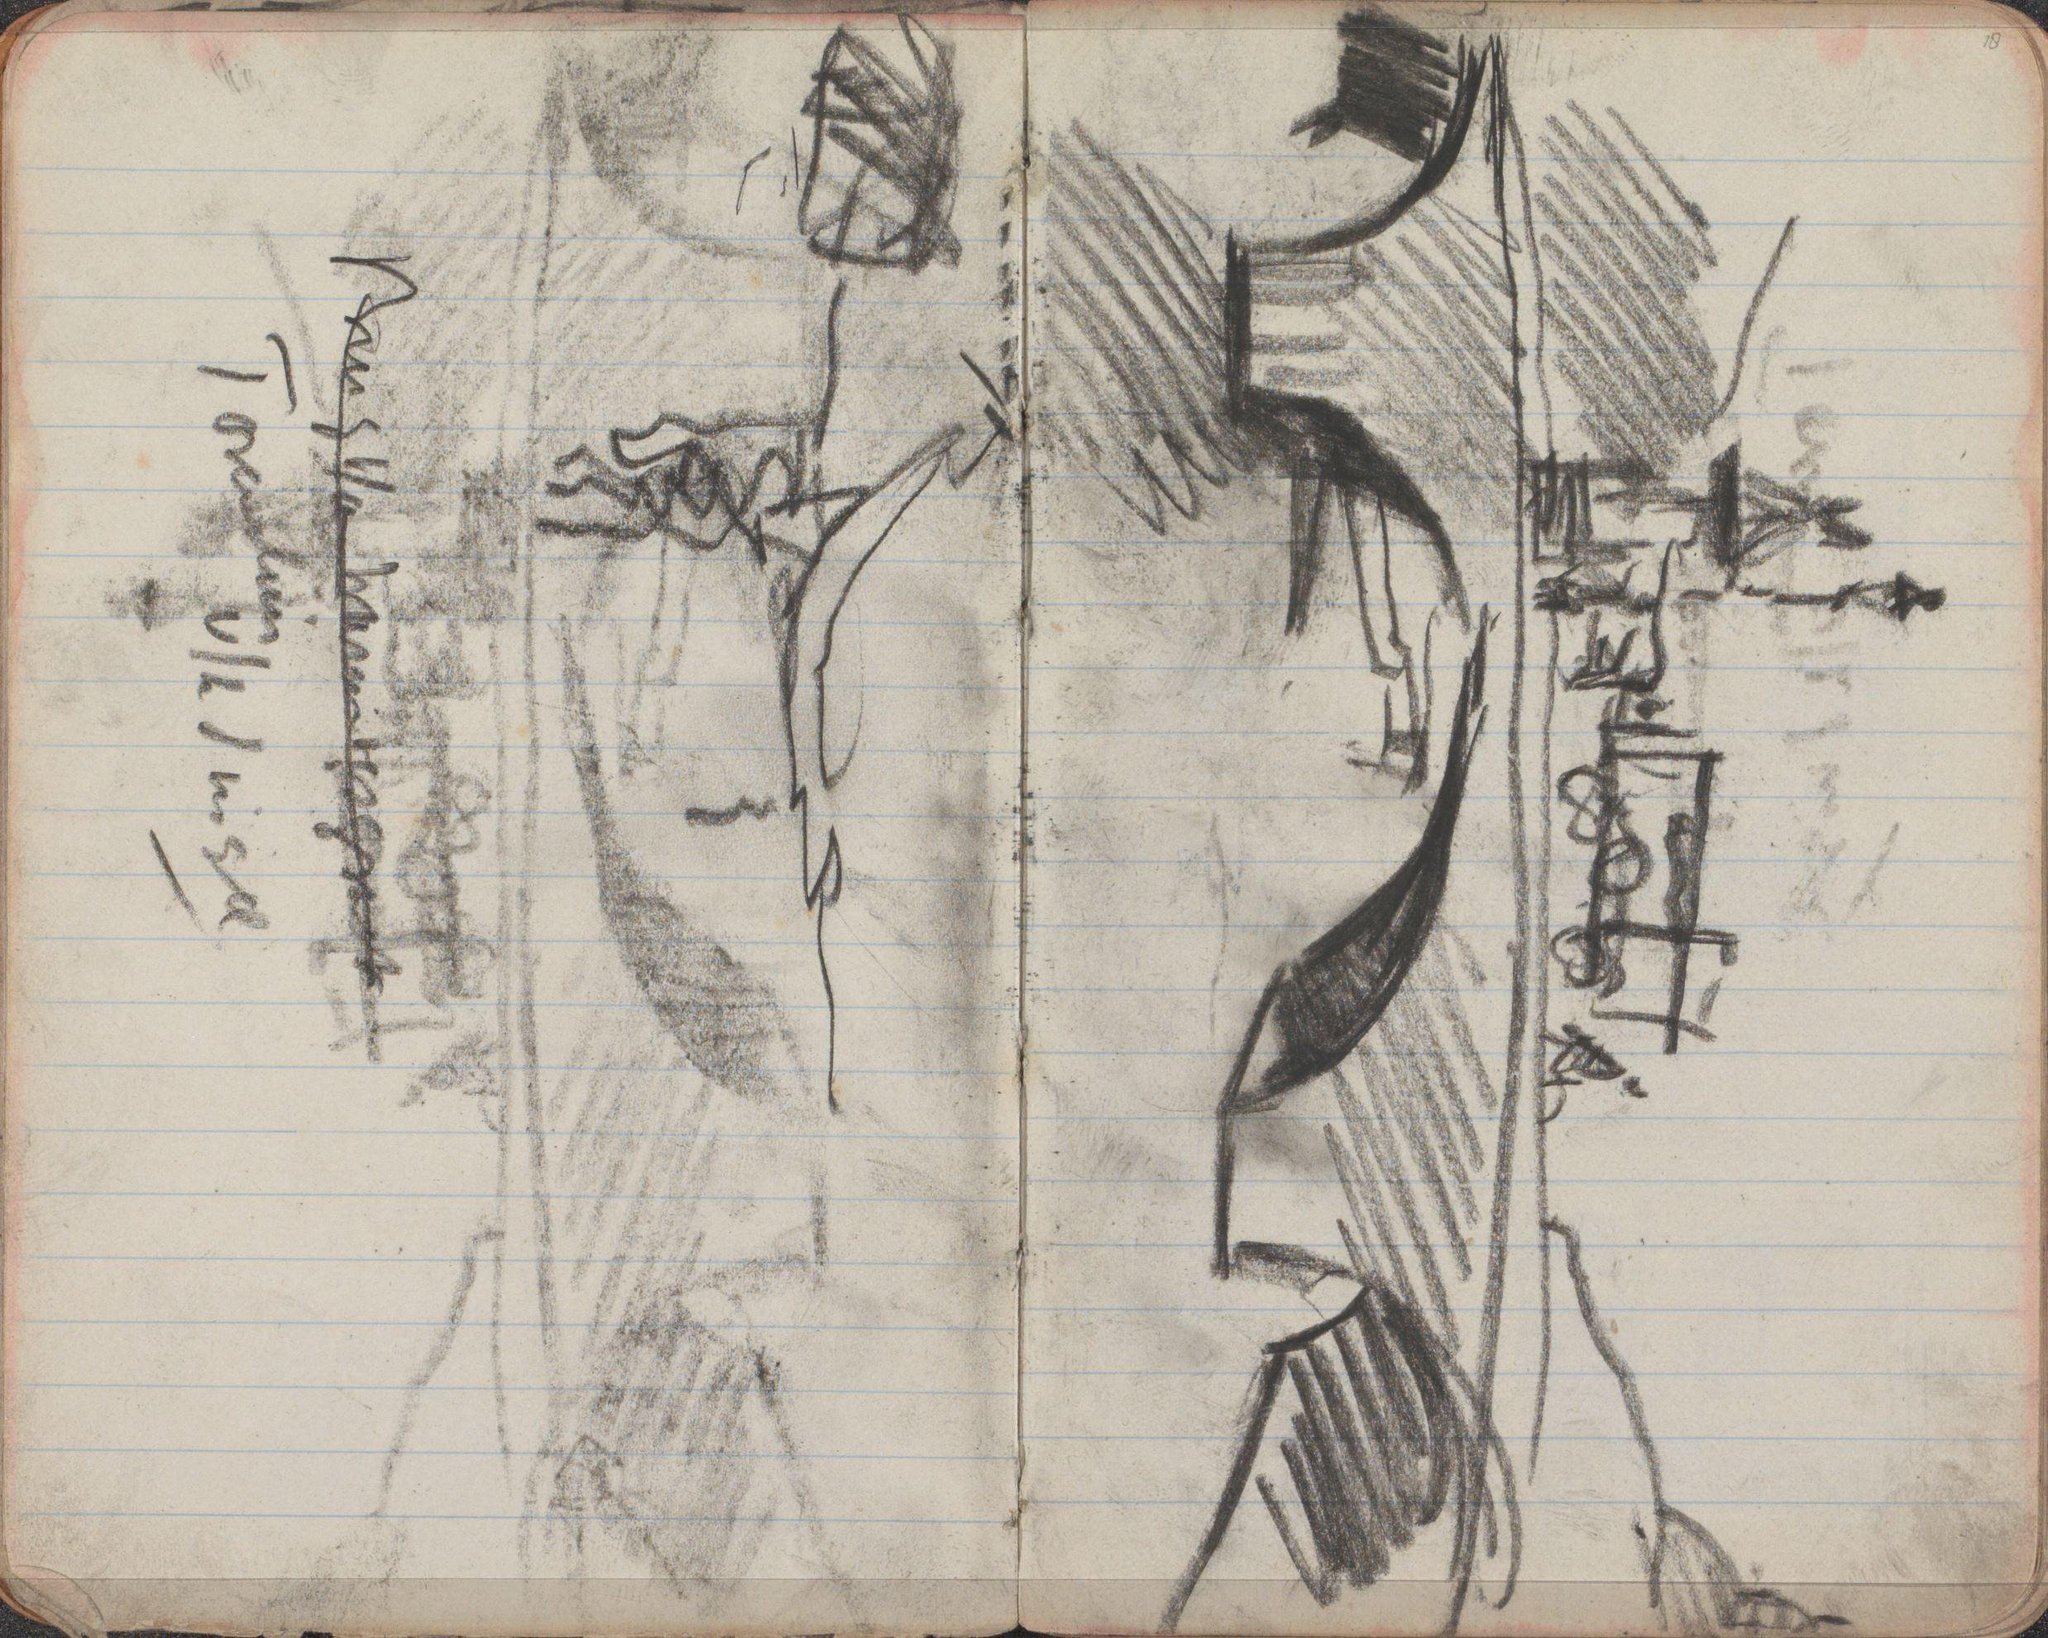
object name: sketchbook leaf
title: Gezicht op de Torensluis over het Singel te Amsterdam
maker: george hendrik breitner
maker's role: draughtsman, painter, print maker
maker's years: 1857-1923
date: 1892-1900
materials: chalk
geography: amsterdam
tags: bridge in city across river, canal, etc. (+ city(-scape) with figures, staffage), church (exterior), civic architecture; edifices; dwellings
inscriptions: annotation: ‘Brug [...] Warmoesgracht [doorgestreept]/ Torensluis v/h Singel’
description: In de verte de koepel van de Ronde Lutherse Kerk. Pagina 17 en pagina 18 uit een schetsboek met 38 bladen.